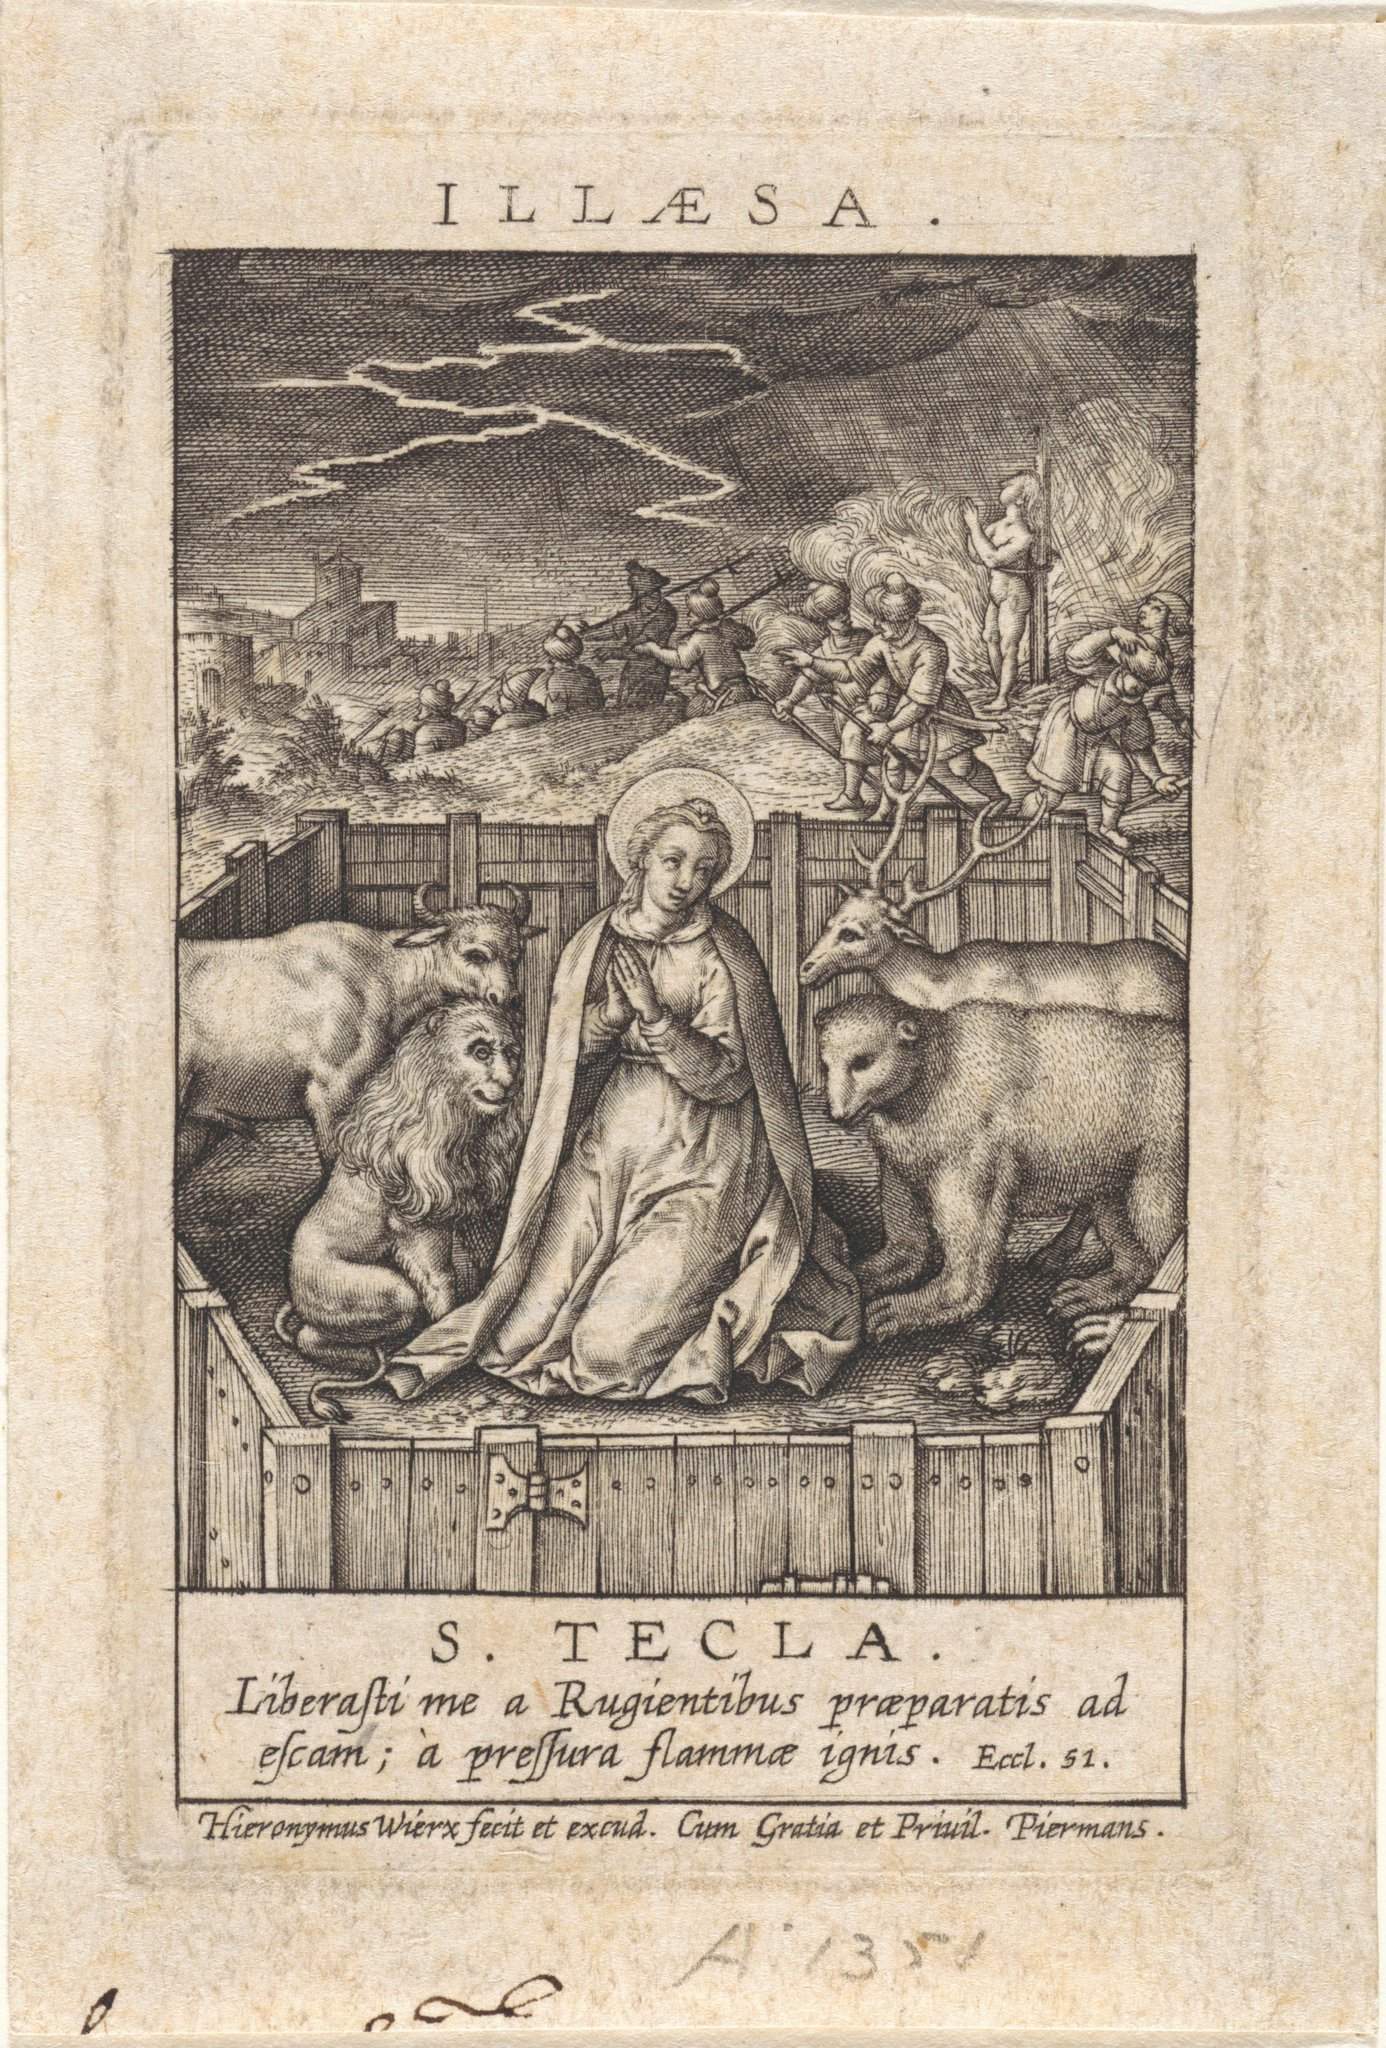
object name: print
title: Deugdzaamheid van de ongeschondenen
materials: paper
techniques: engraving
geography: antwerp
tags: hoofed animals: deer, the virgin martyr thecla of iconium; possible attributes: bear, (ball of) flames, lion, pillar, serpents, st. thecla is tied to the stake, but the flames do not harm her, beasts of prey, predatory animals: lion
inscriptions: collector's mark: Lugt 2228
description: De heilige Thecla van Iconium omringd door een leeuw, een beer, een stier en een hert. Op de achtergrond is ze op een berg aan een paal gebonden door soldaten. De vlammen hebben echter geen vat op haar. In de marge een tweeregelig Bijbelcitaat uit Sir. 51 in het Latijn.